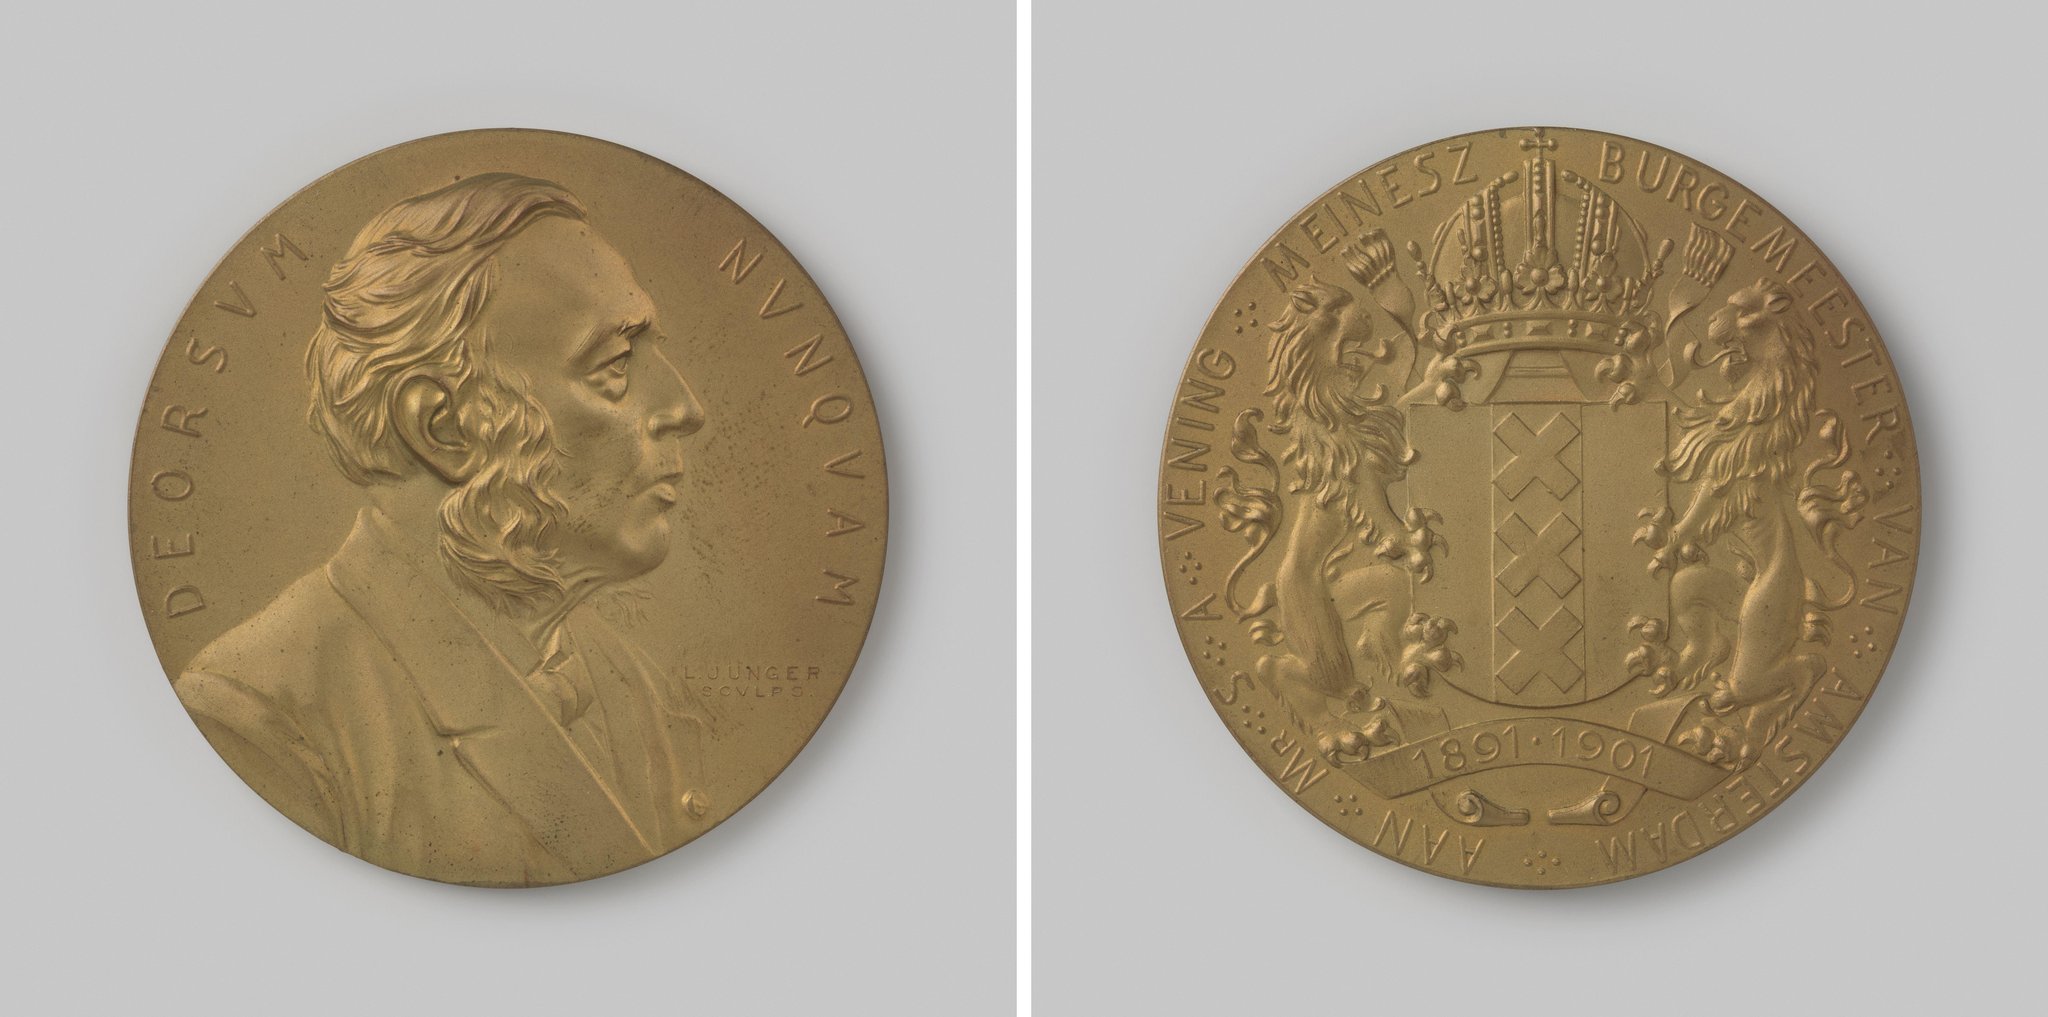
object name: history medal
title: Tienjarig jubileum van de burgemeester van Amsterdam Mr. S.A. Vening Meinesz 1901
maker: j.a.a. gerritsen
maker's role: manufacturer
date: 1901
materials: brass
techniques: striking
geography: amsterdam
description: Messing penning, op de voorzijde het borstbeeld van Vening Meinesz naar rechts met omschrift, op de keerzijde het gekroonde Amsterdamse wapenschild gedragen door leeuwen op een tekstlint, met omschift.